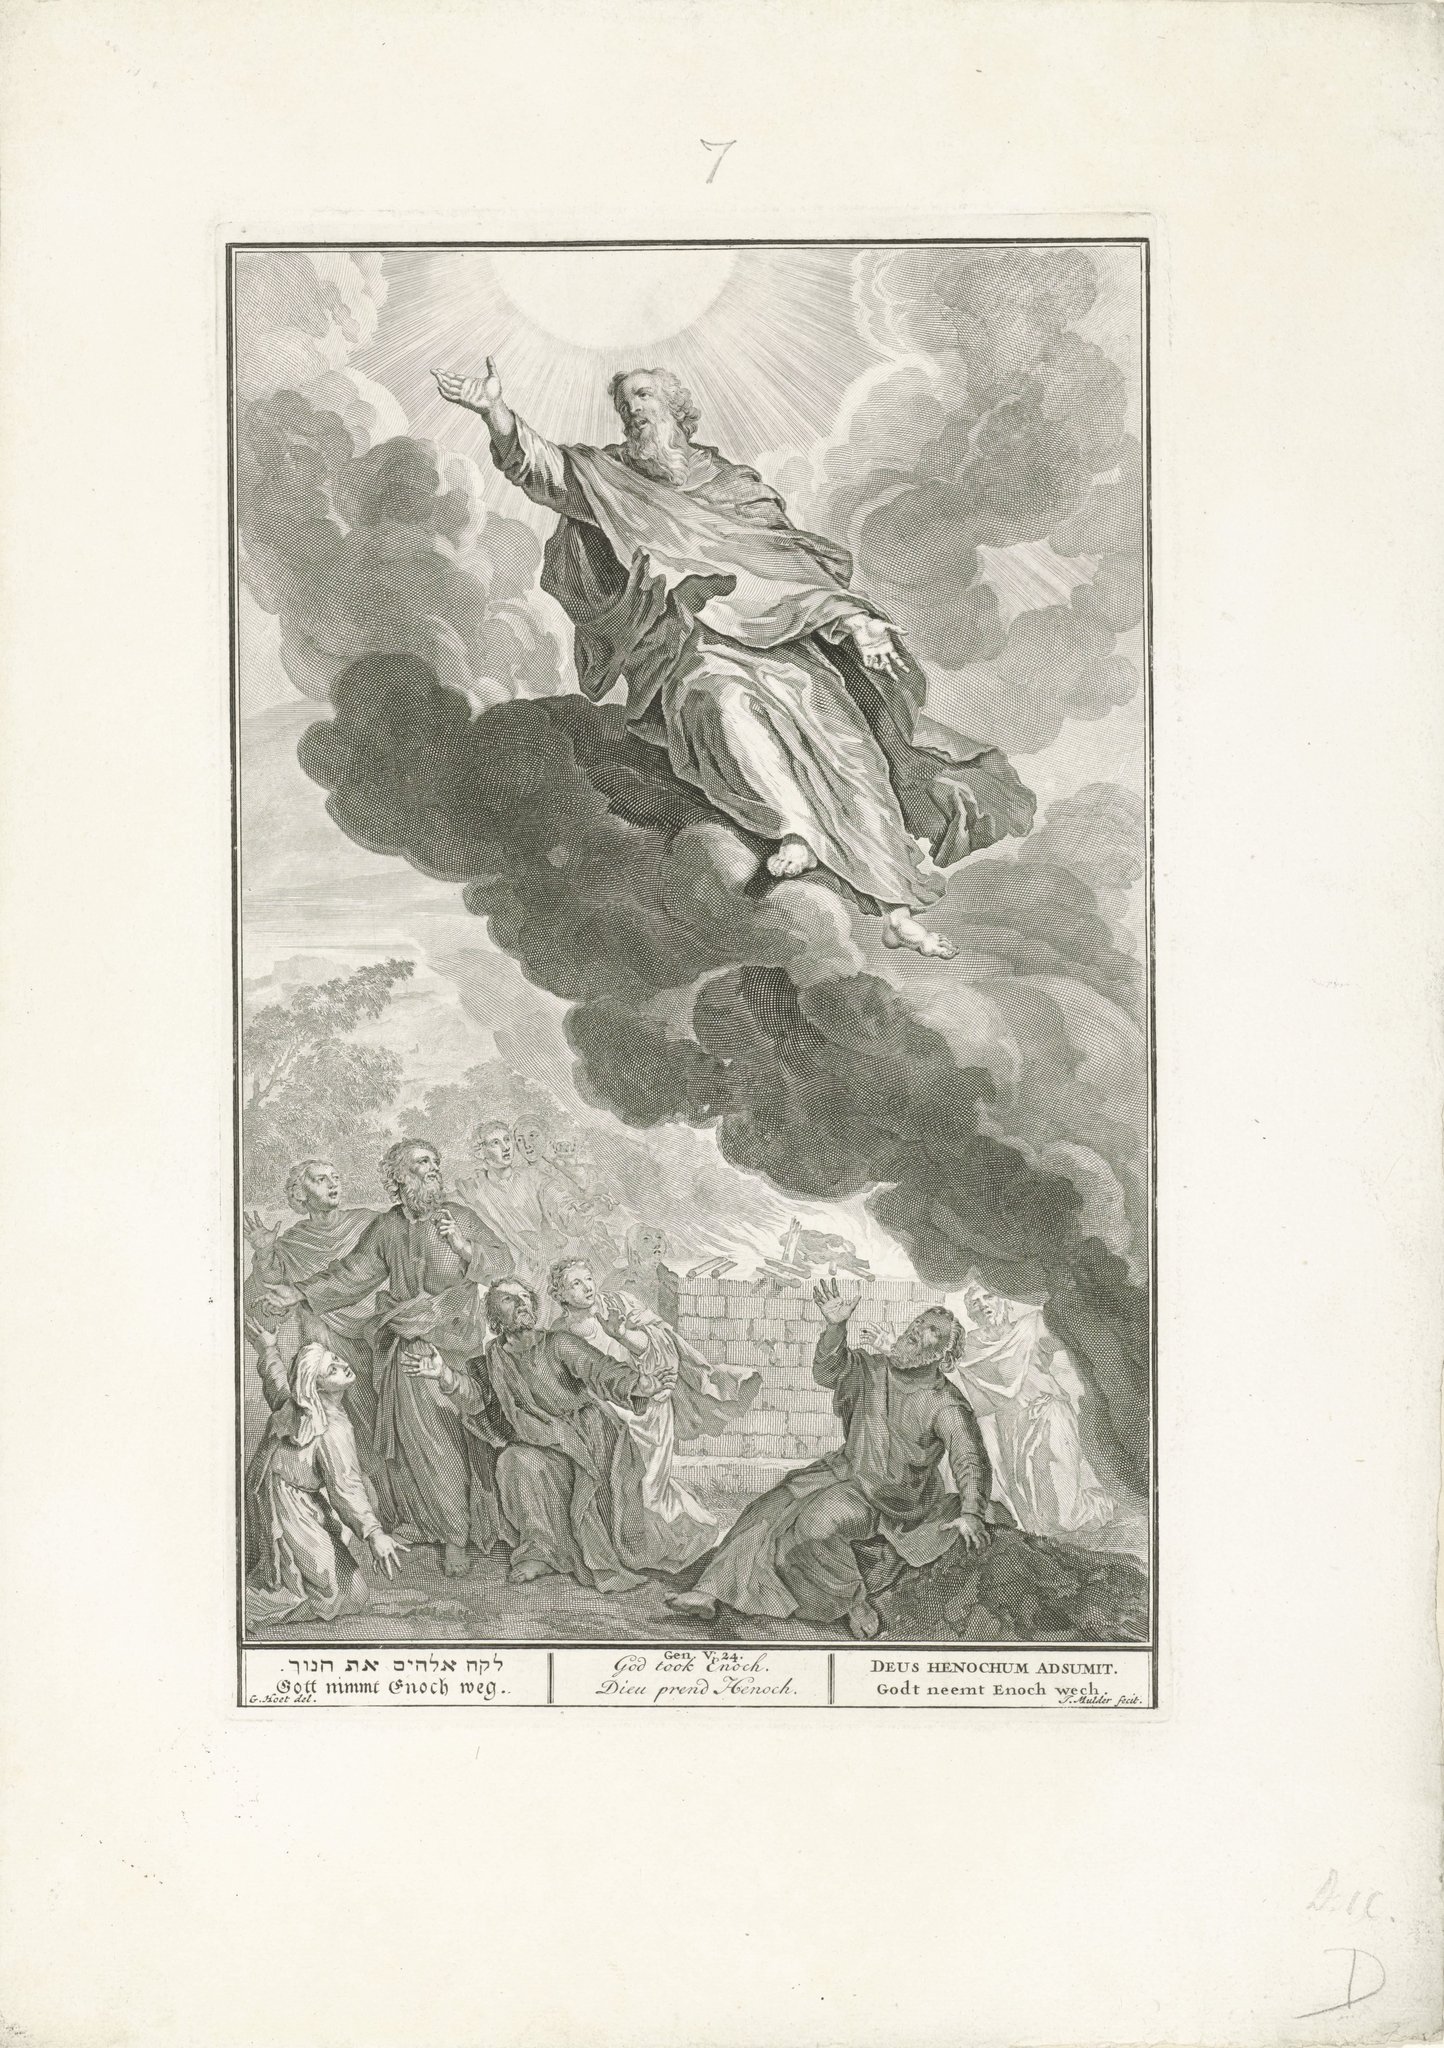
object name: book illustration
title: Hemelvaart van Henoch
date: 1720-1728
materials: paper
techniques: engraving, etching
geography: amsterdam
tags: story of enoch, son of jared, who invented letters and was the first to divide the year into seasons and into twelve months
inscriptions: collector's mark: Lugt 2228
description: Prent gemaakt voor: Figures de la Bible. Amsterdam, Bernard Picart, 1720. Prent ook gebruikt in: Taferelen der voornaamste geschiedenissen van het Oude en Nieuwe Testament (...) door de vermaarde kunstenaars Hoet, Houbraken, en Picart getekent (...) en met beschrijvingen uitgebreid. Den Haag: Pieter de Hondt, 1728.